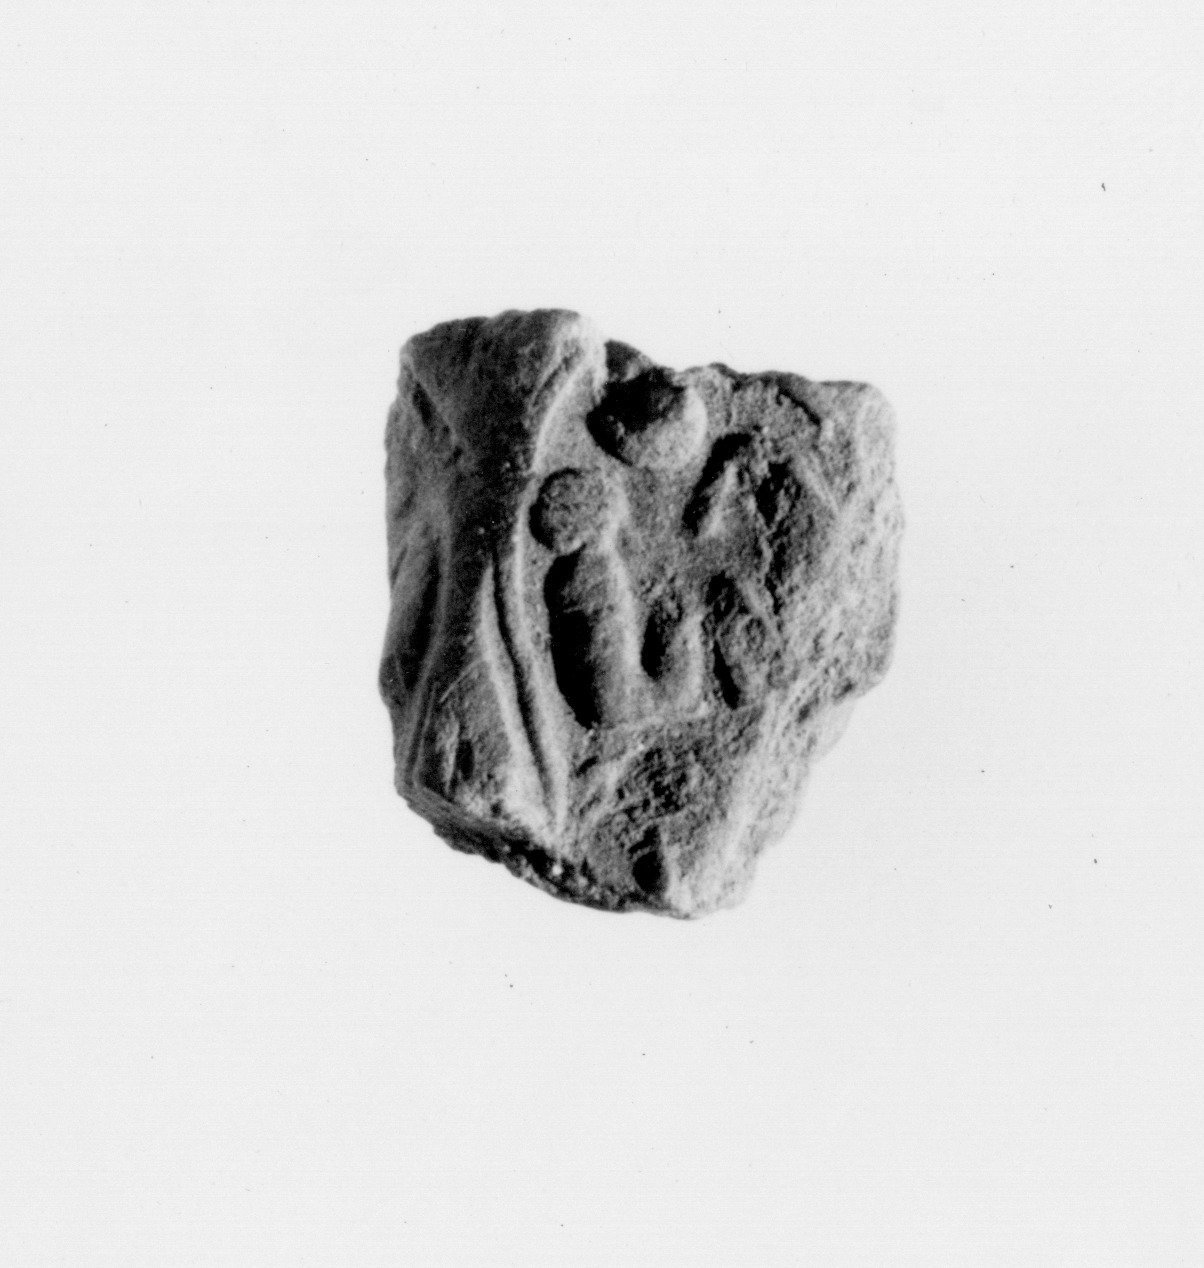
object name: sealing, nebmaatre, amenhotep iii, horus, re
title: Document Sealing With the Throne Name of Amenhotep III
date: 1390-1352 BCE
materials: mud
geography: egypt